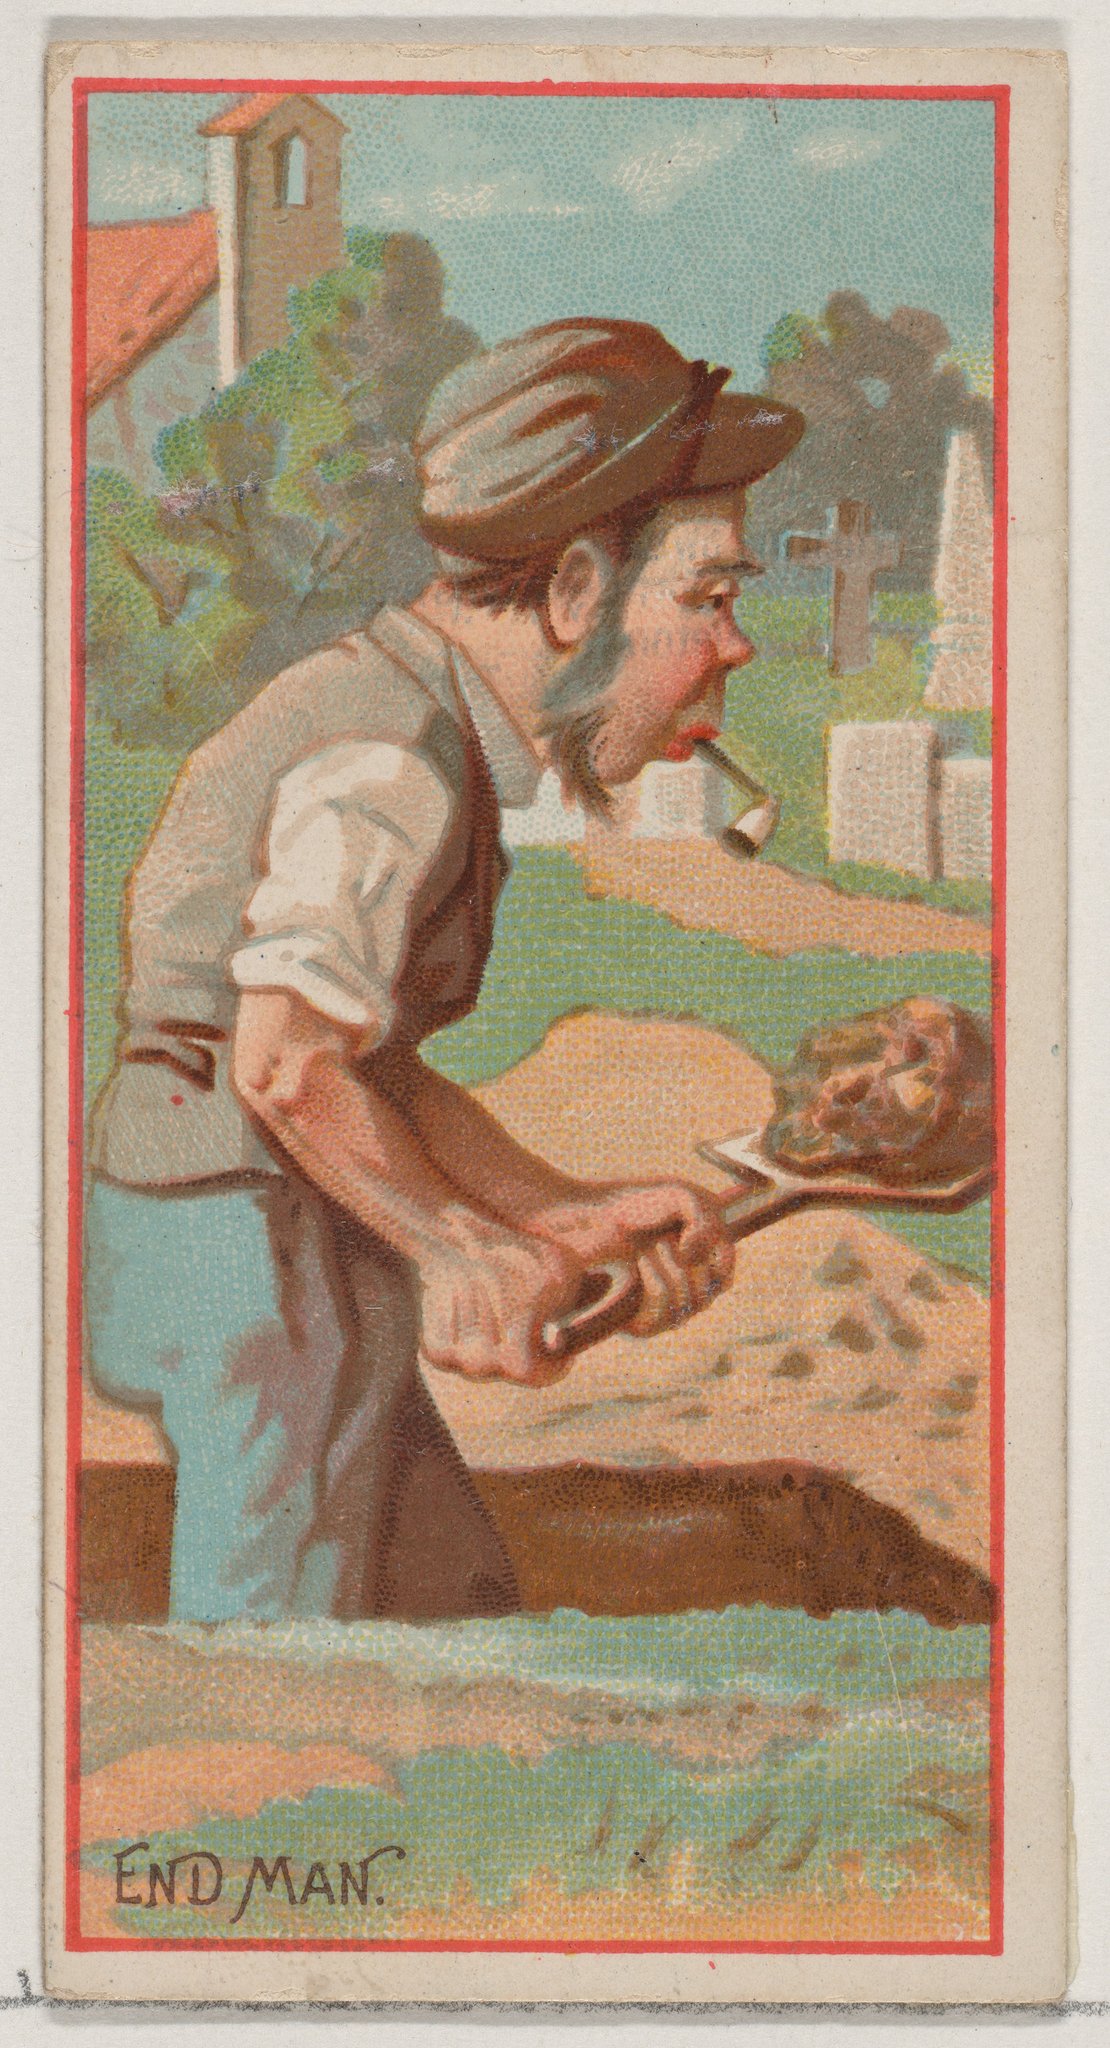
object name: print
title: End Man, from the Jokes series (N87) for Duke brand cigarettes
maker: w. duke, sons & co.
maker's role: publisher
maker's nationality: american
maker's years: 1870-1920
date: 1890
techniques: color lithograph